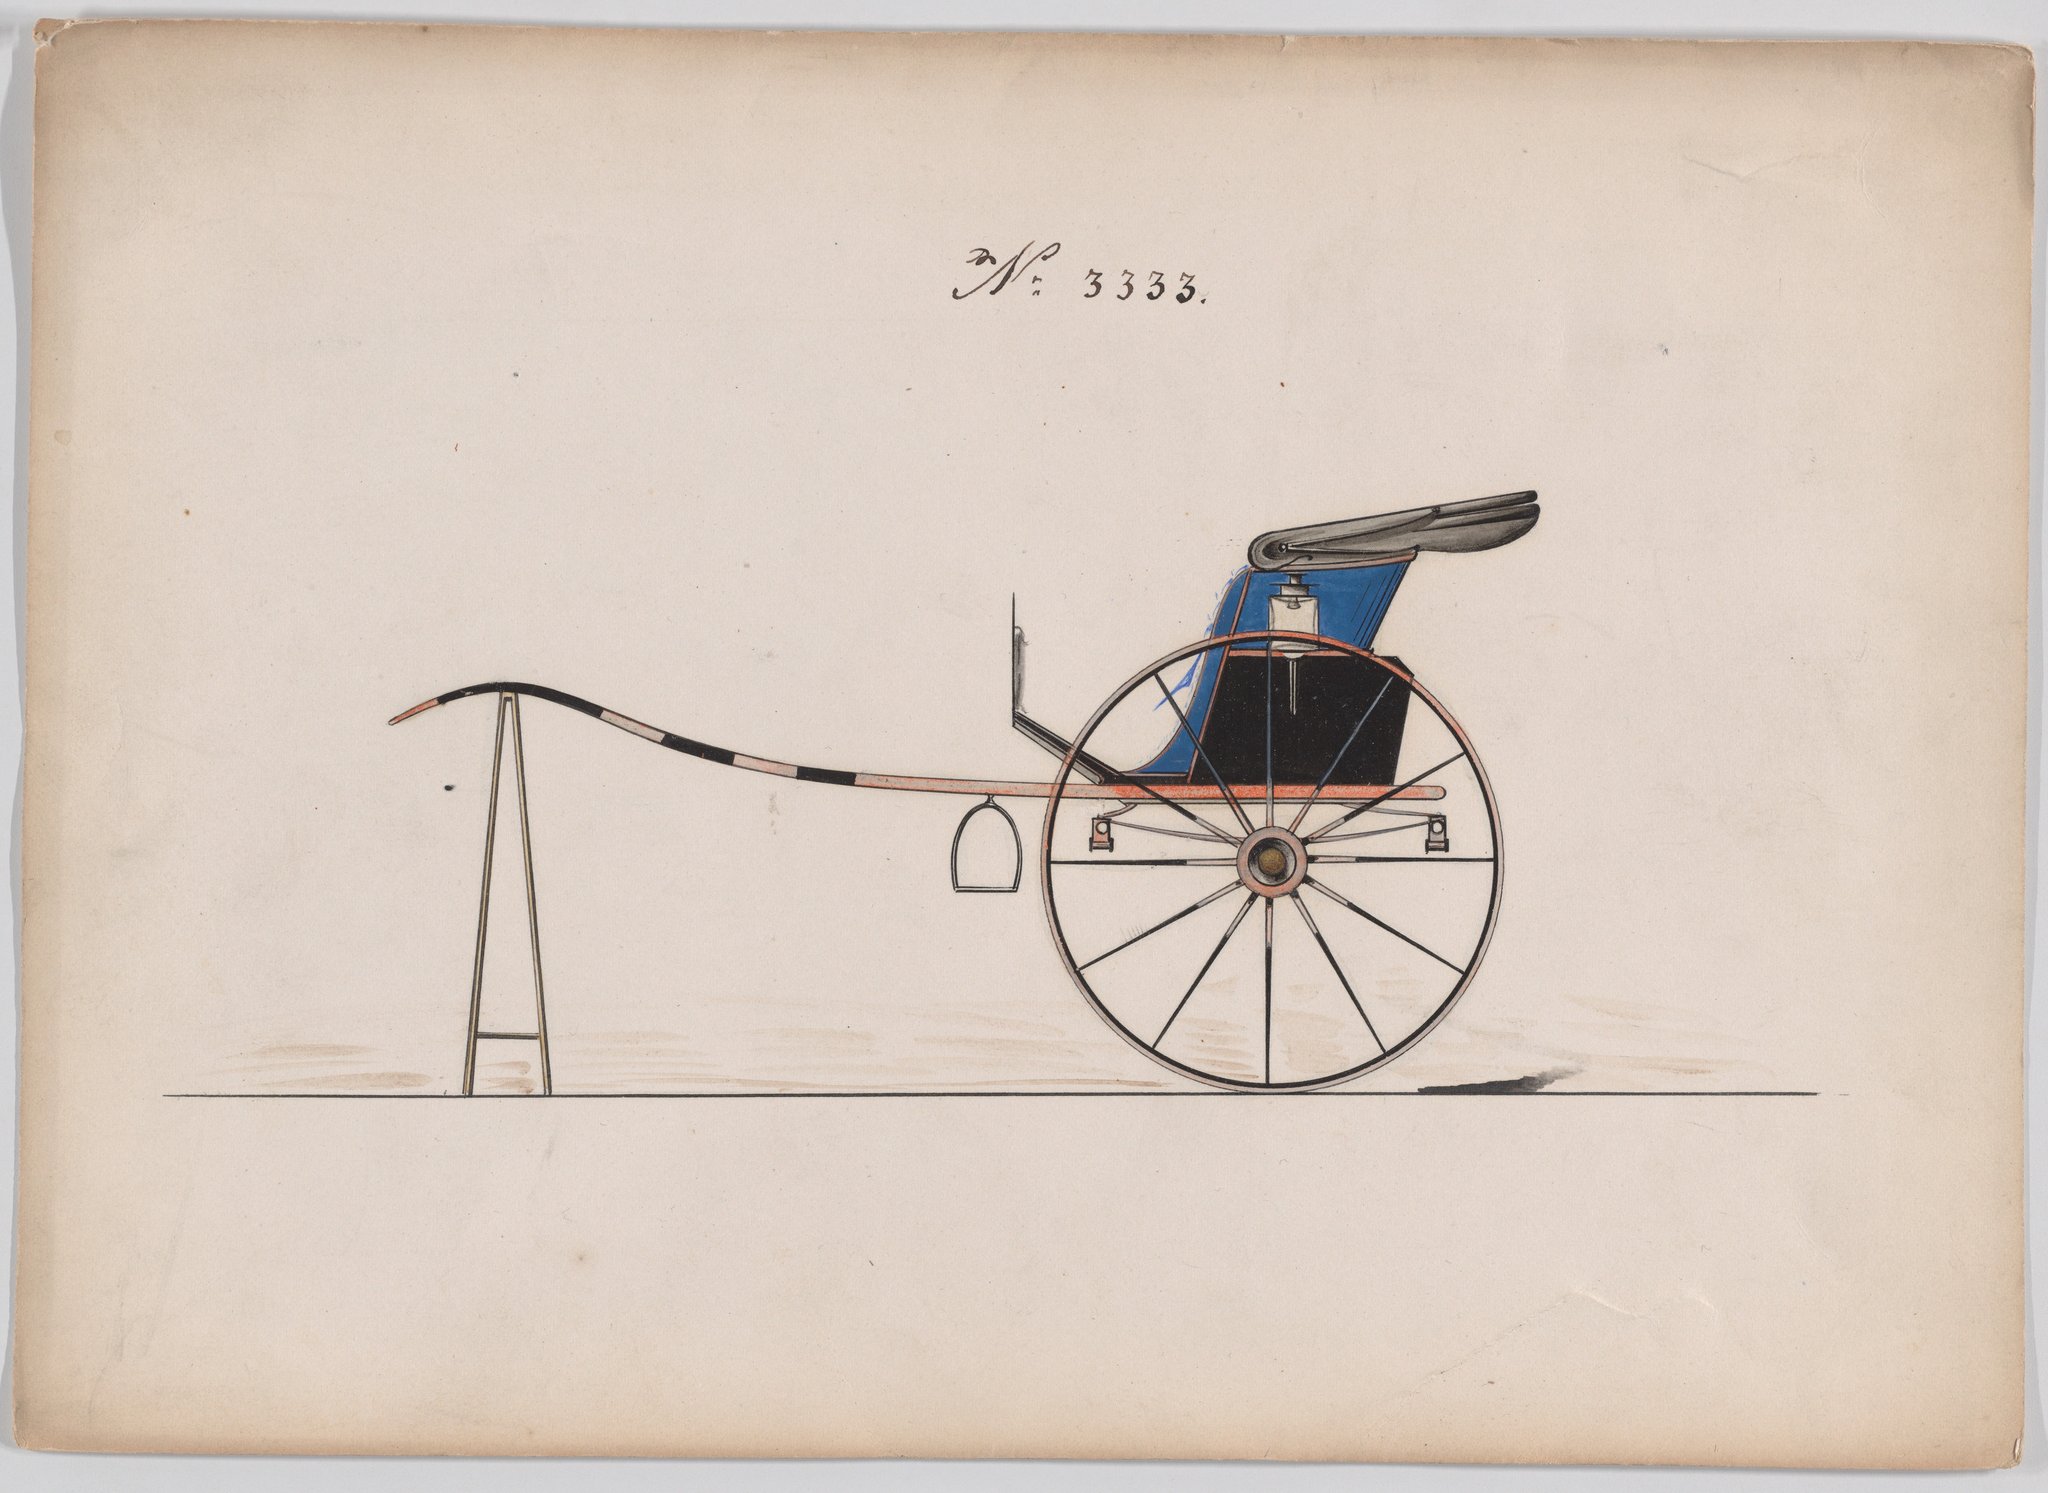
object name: drawing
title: Stanhope Gig #3333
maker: brewster & co.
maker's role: manufacturer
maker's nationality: american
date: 1877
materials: gouache, gum arabic, watercolor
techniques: pen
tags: carriages